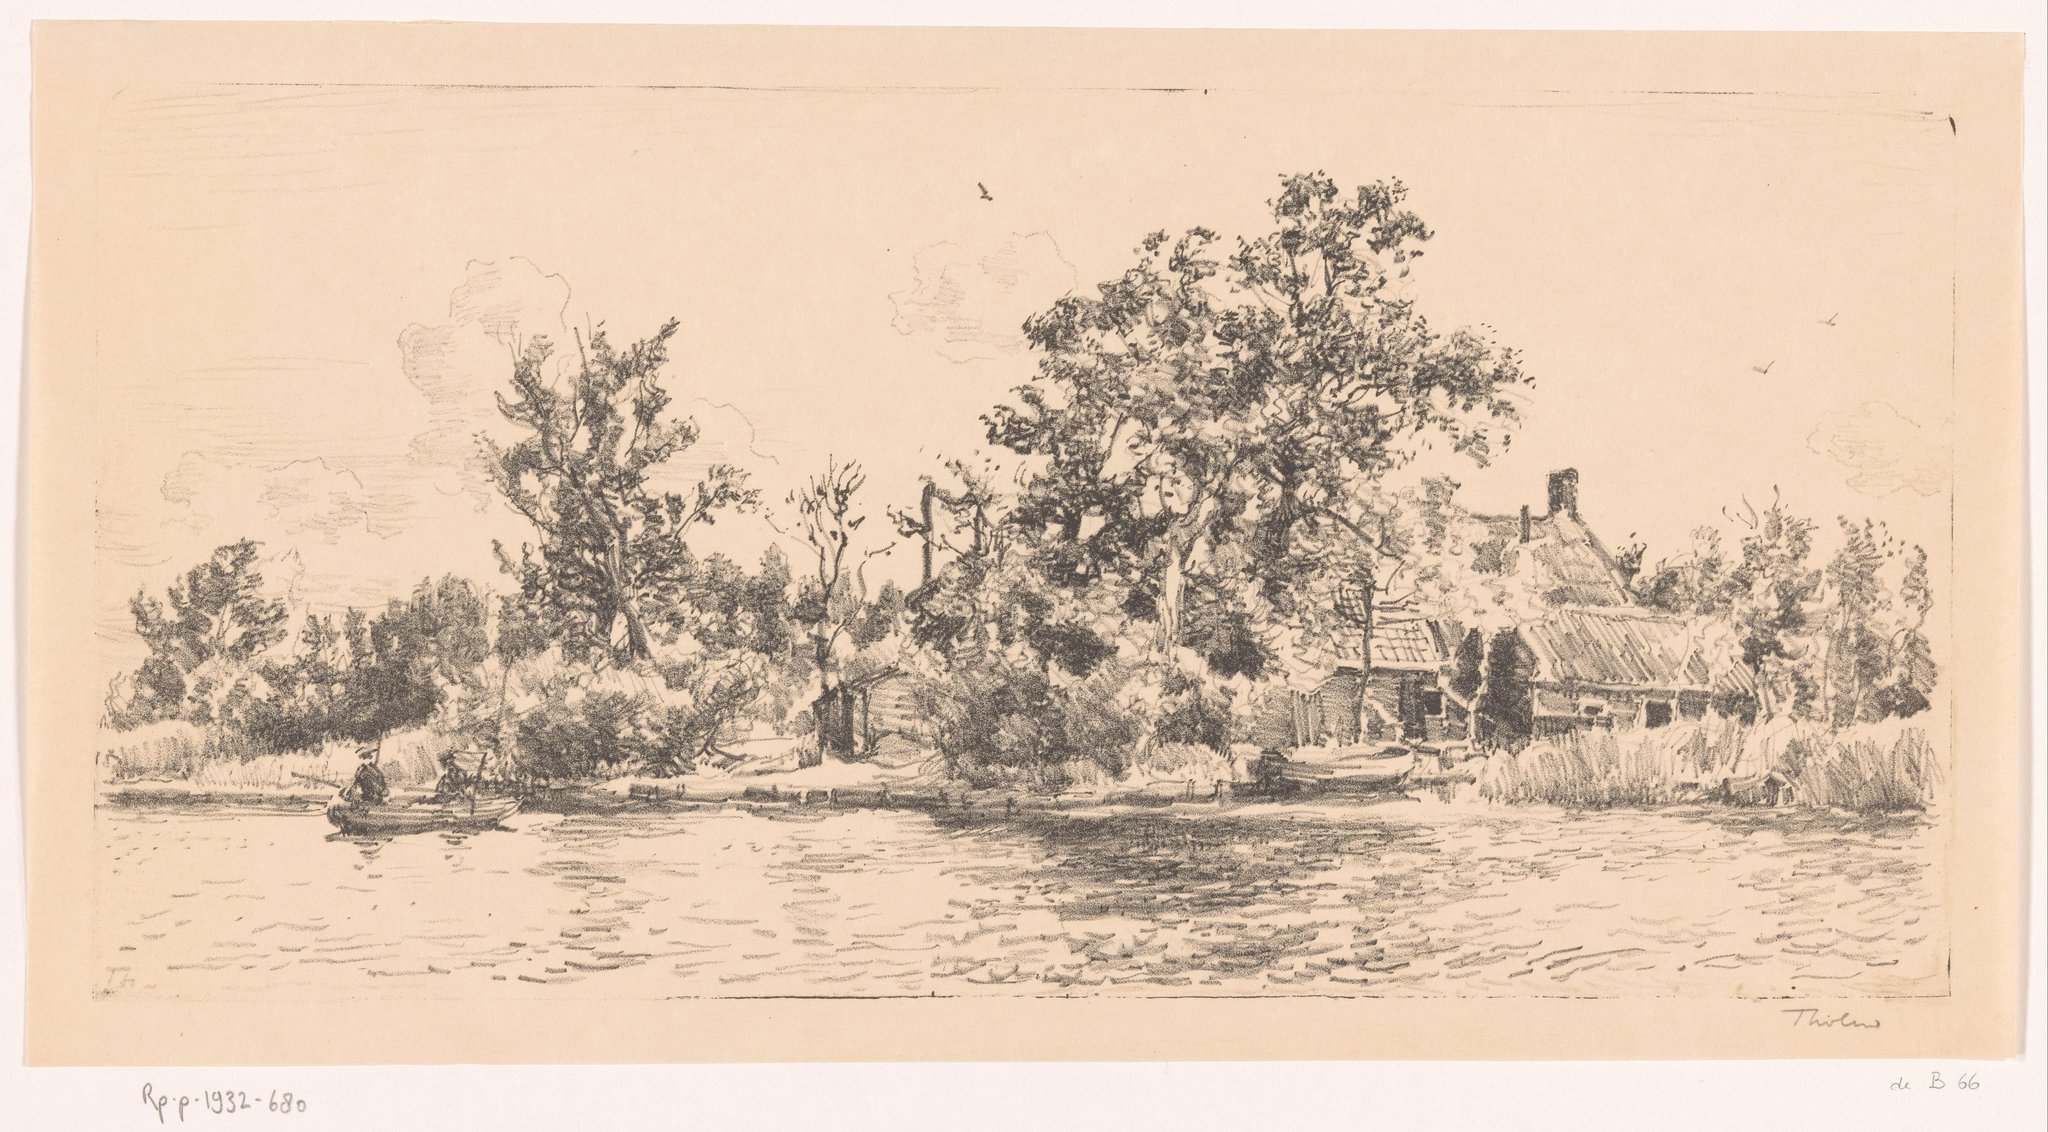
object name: print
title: Landschap met boerderij en hengelaars in een boot op het water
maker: willem bastiaan tholen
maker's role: draughtsman, painter, print maker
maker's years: 1860-1931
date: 1870-1931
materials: paper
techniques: lithograph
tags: rowing-boat, canoe, etc., farm or solitary house in landscape, fisherman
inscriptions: collector's mark: Lugt 2228